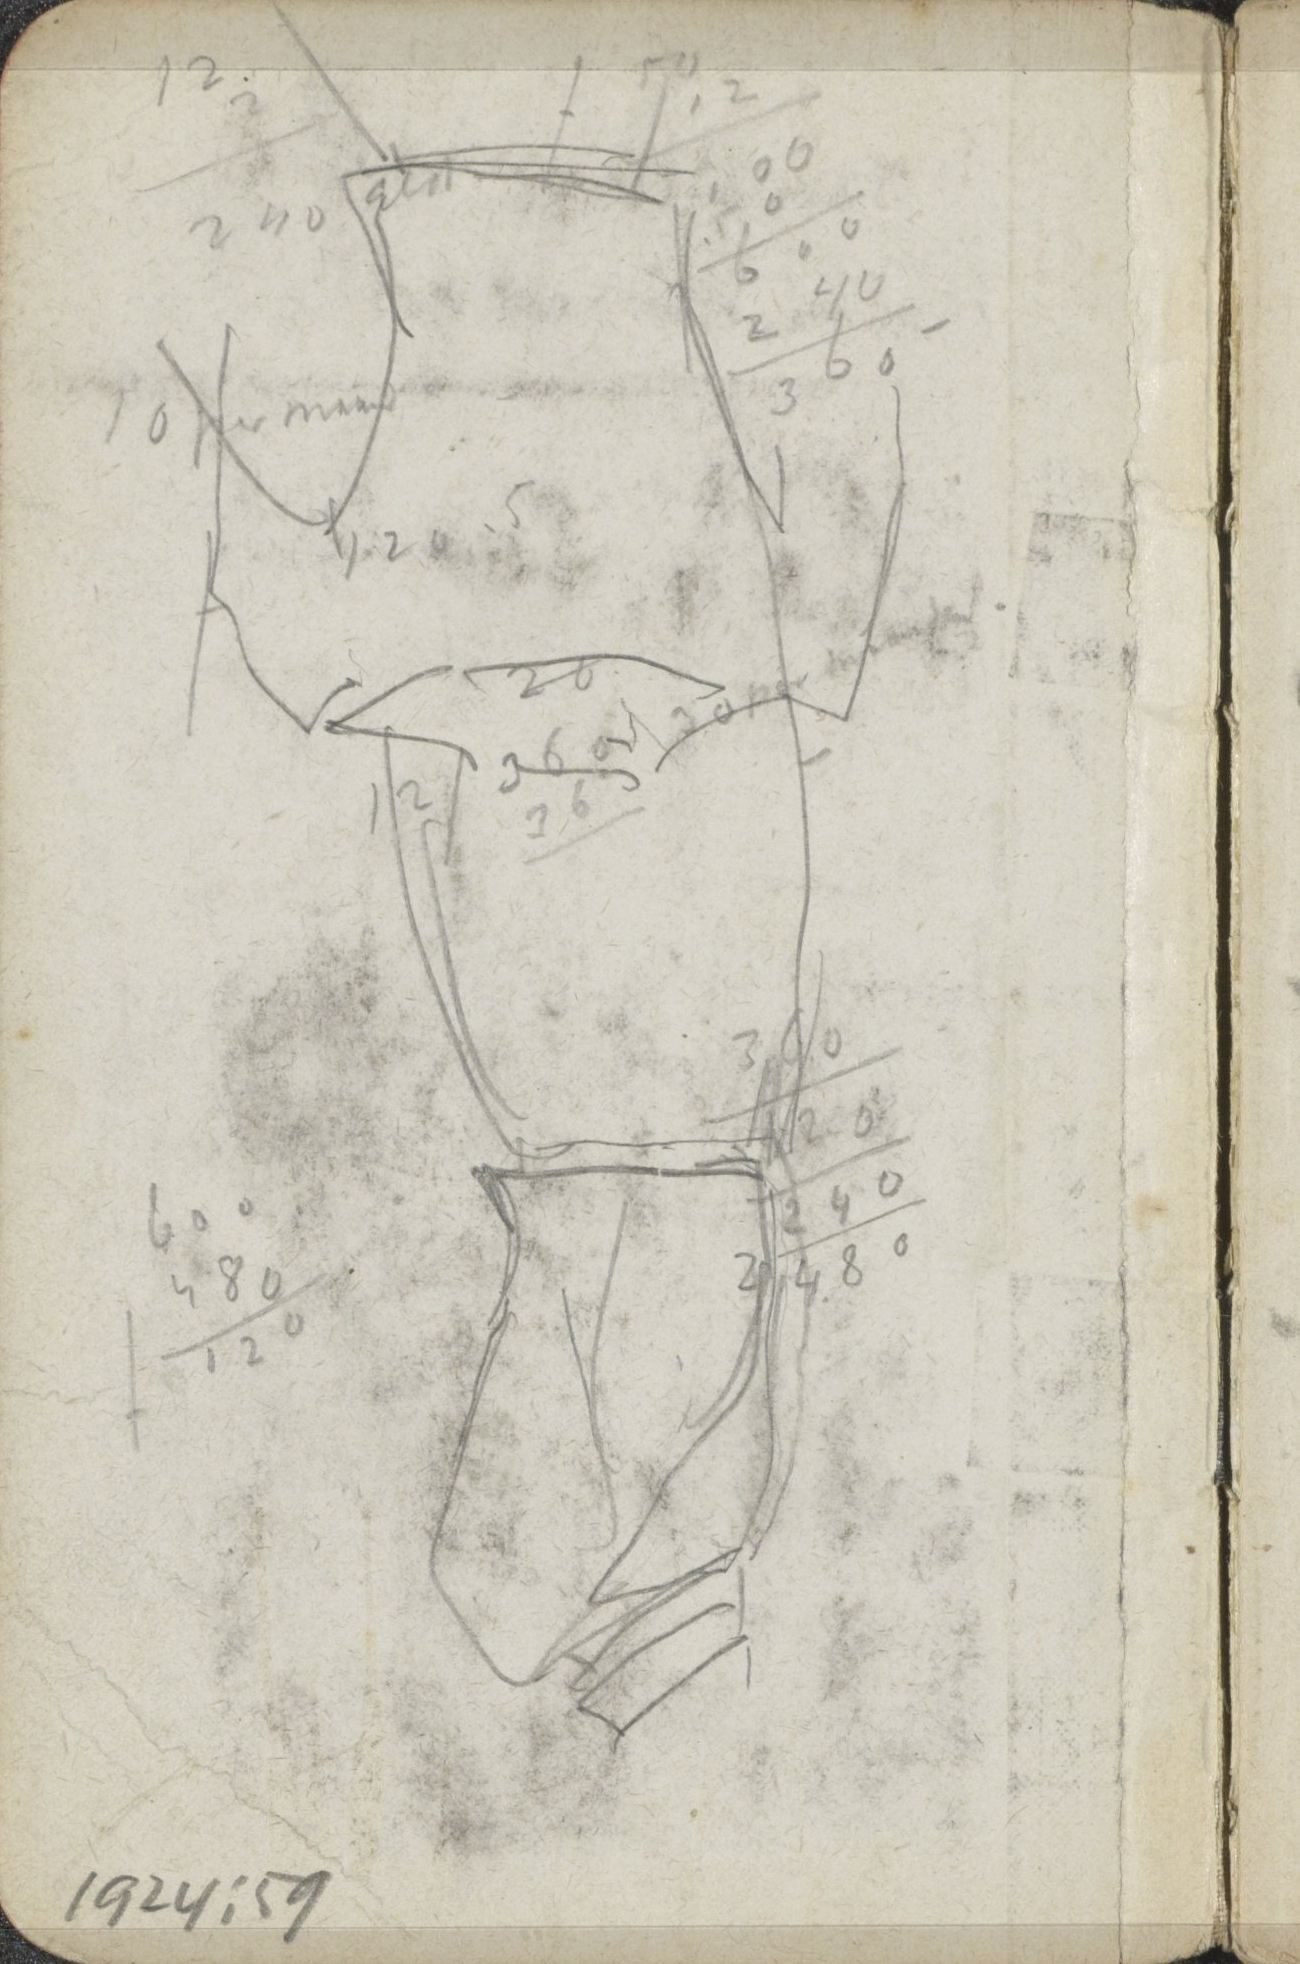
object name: endleaf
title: Kostuumstudies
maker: george hendrik breitner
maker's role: draughtsman, painter, print maker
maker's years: 1857-1923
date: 1893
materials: paper, pencil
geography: amsterdam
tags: clothes, costume (+ women's clothes)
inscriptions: annotation: ‘[...]’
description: Pagina 1, voorste schutblad, uit een schetsboek met 38 bladen.